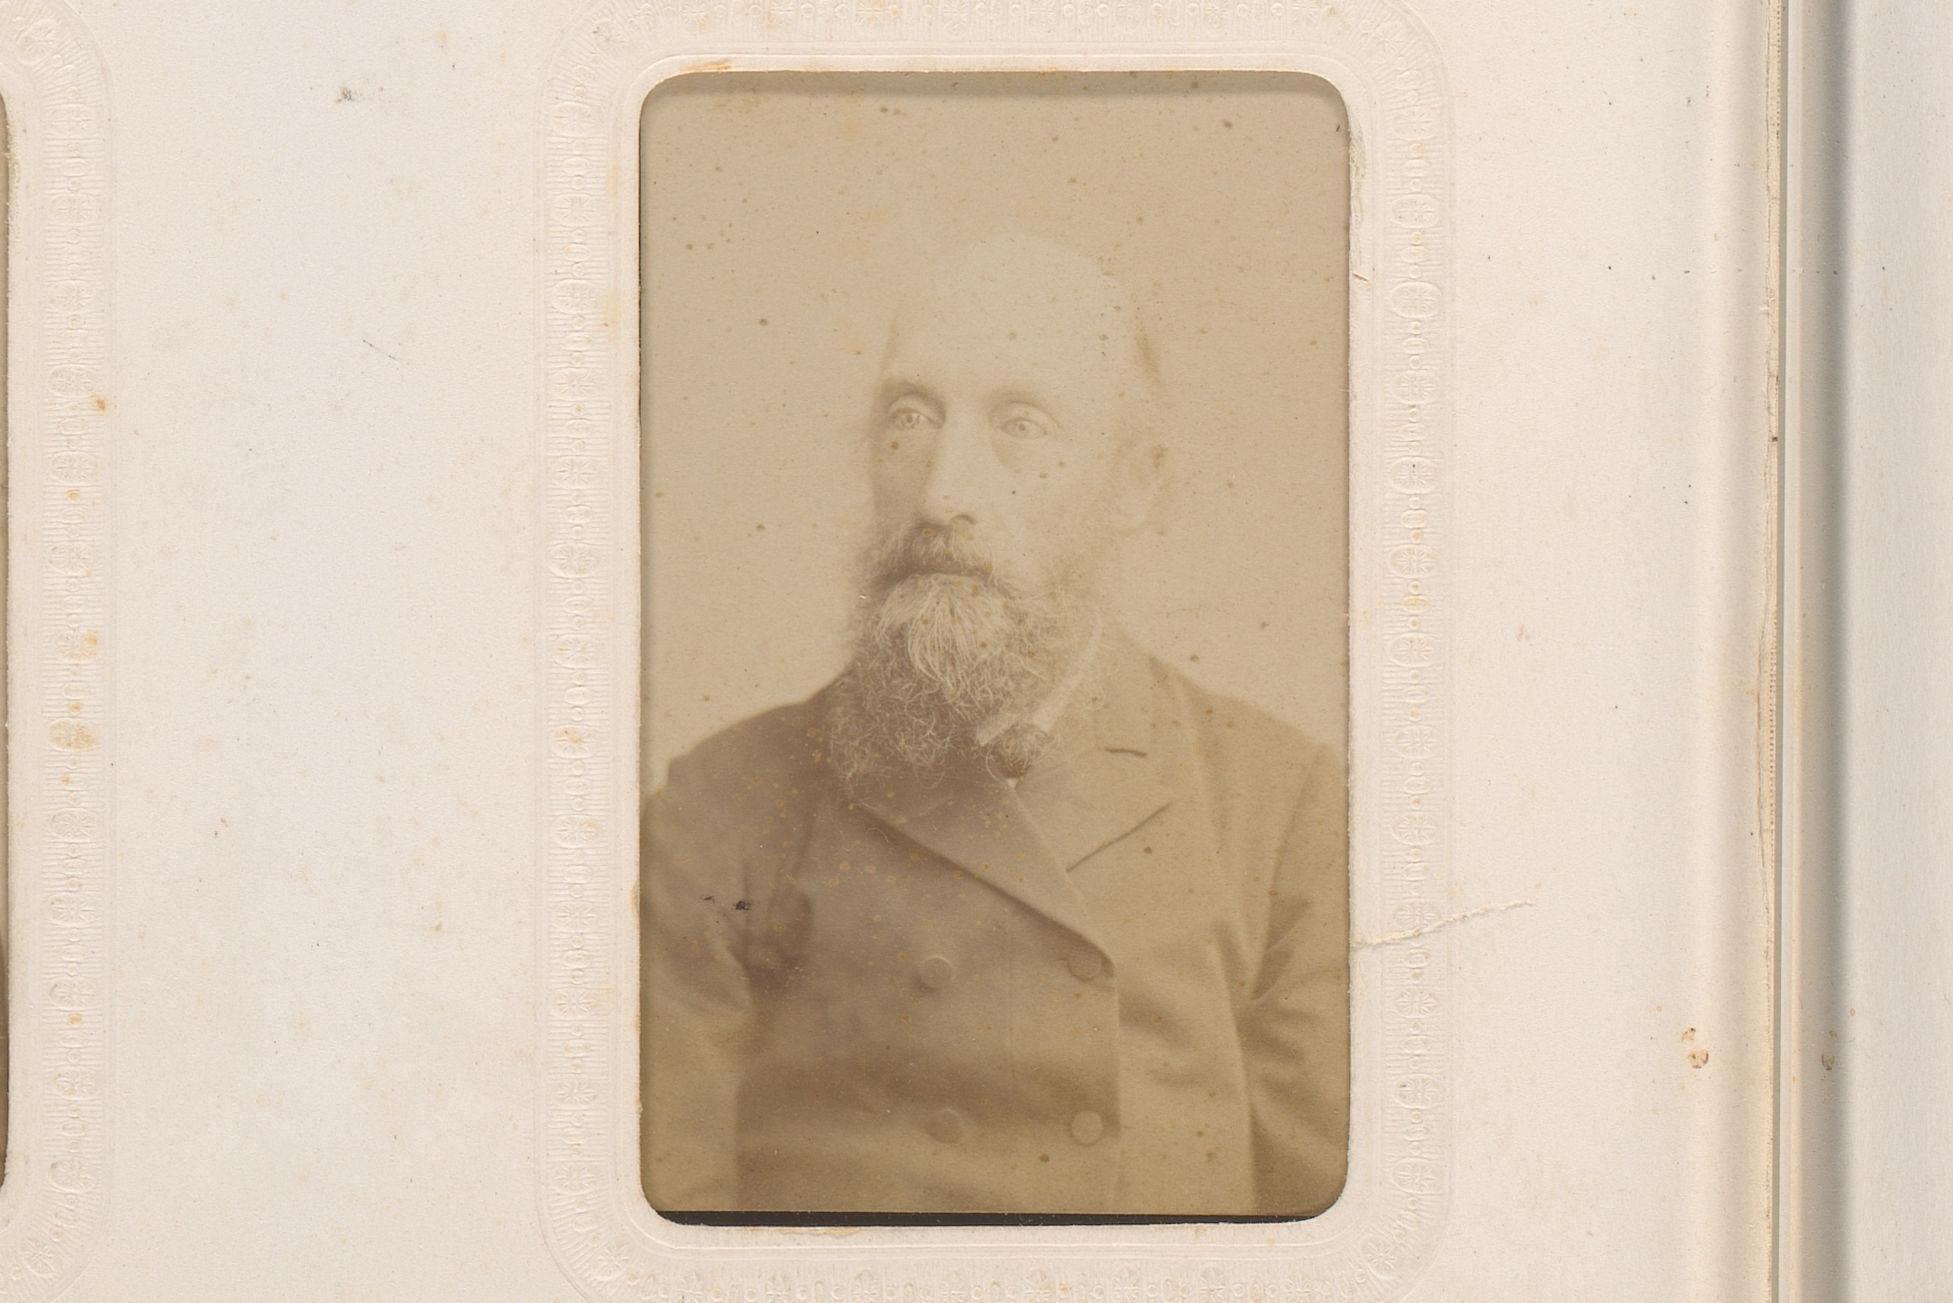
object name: carte de visite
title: Portret van een man met snor en baard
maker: Anonymous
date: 1860-1900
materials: cardboard, photographic support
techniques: albumen print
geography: netherlands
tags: moustache, historical persons, beard